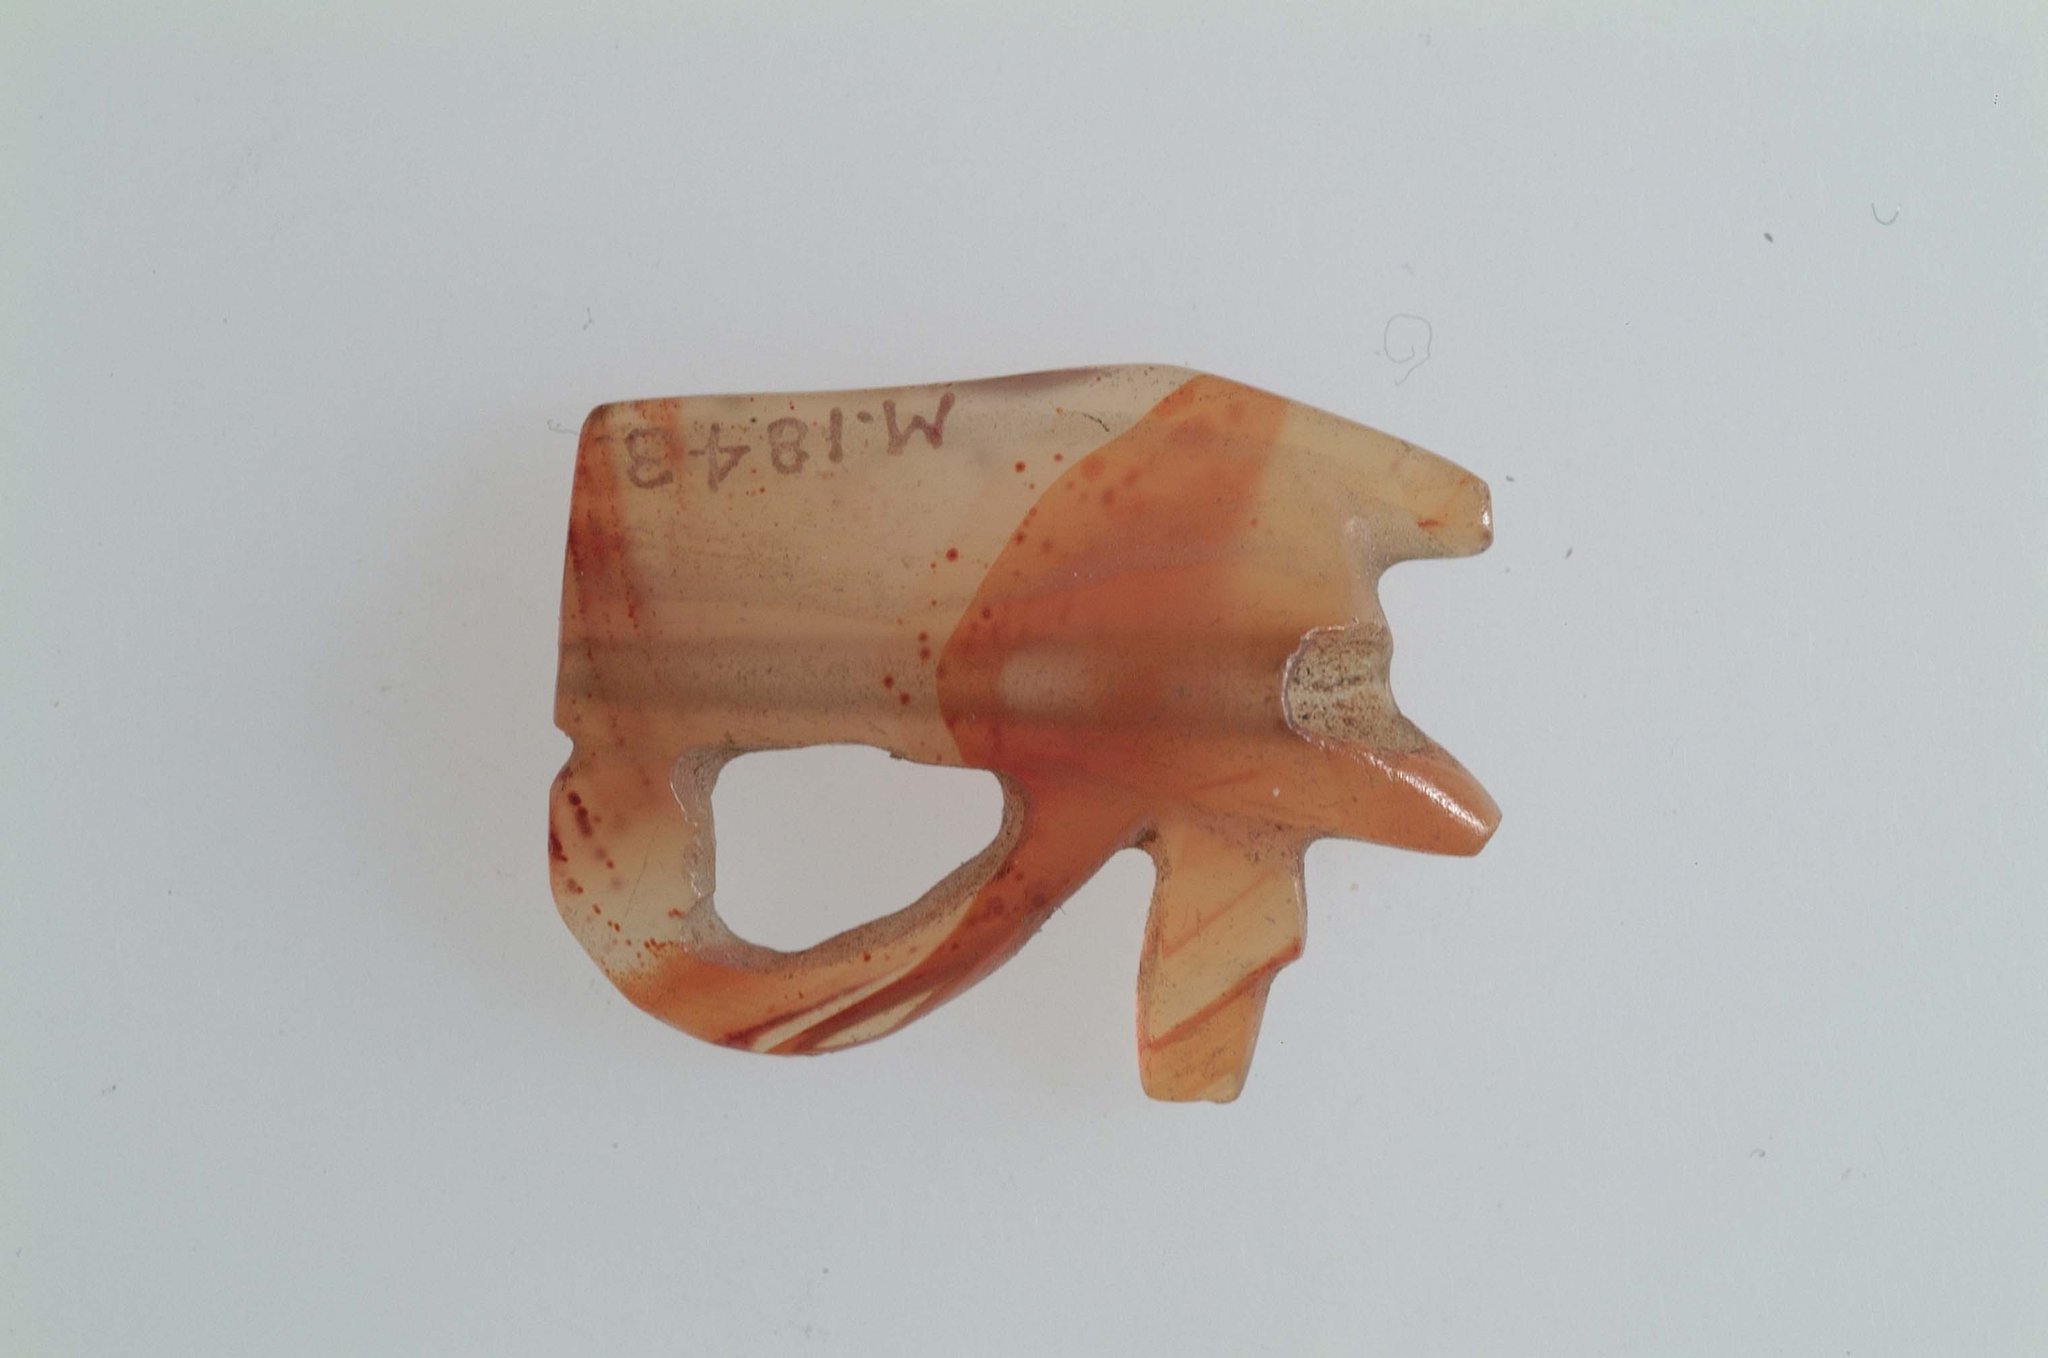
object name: amulet, wedjat eye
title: Wedjat Eye Amulet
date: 1550-1070 BCE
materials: stone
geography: egypt